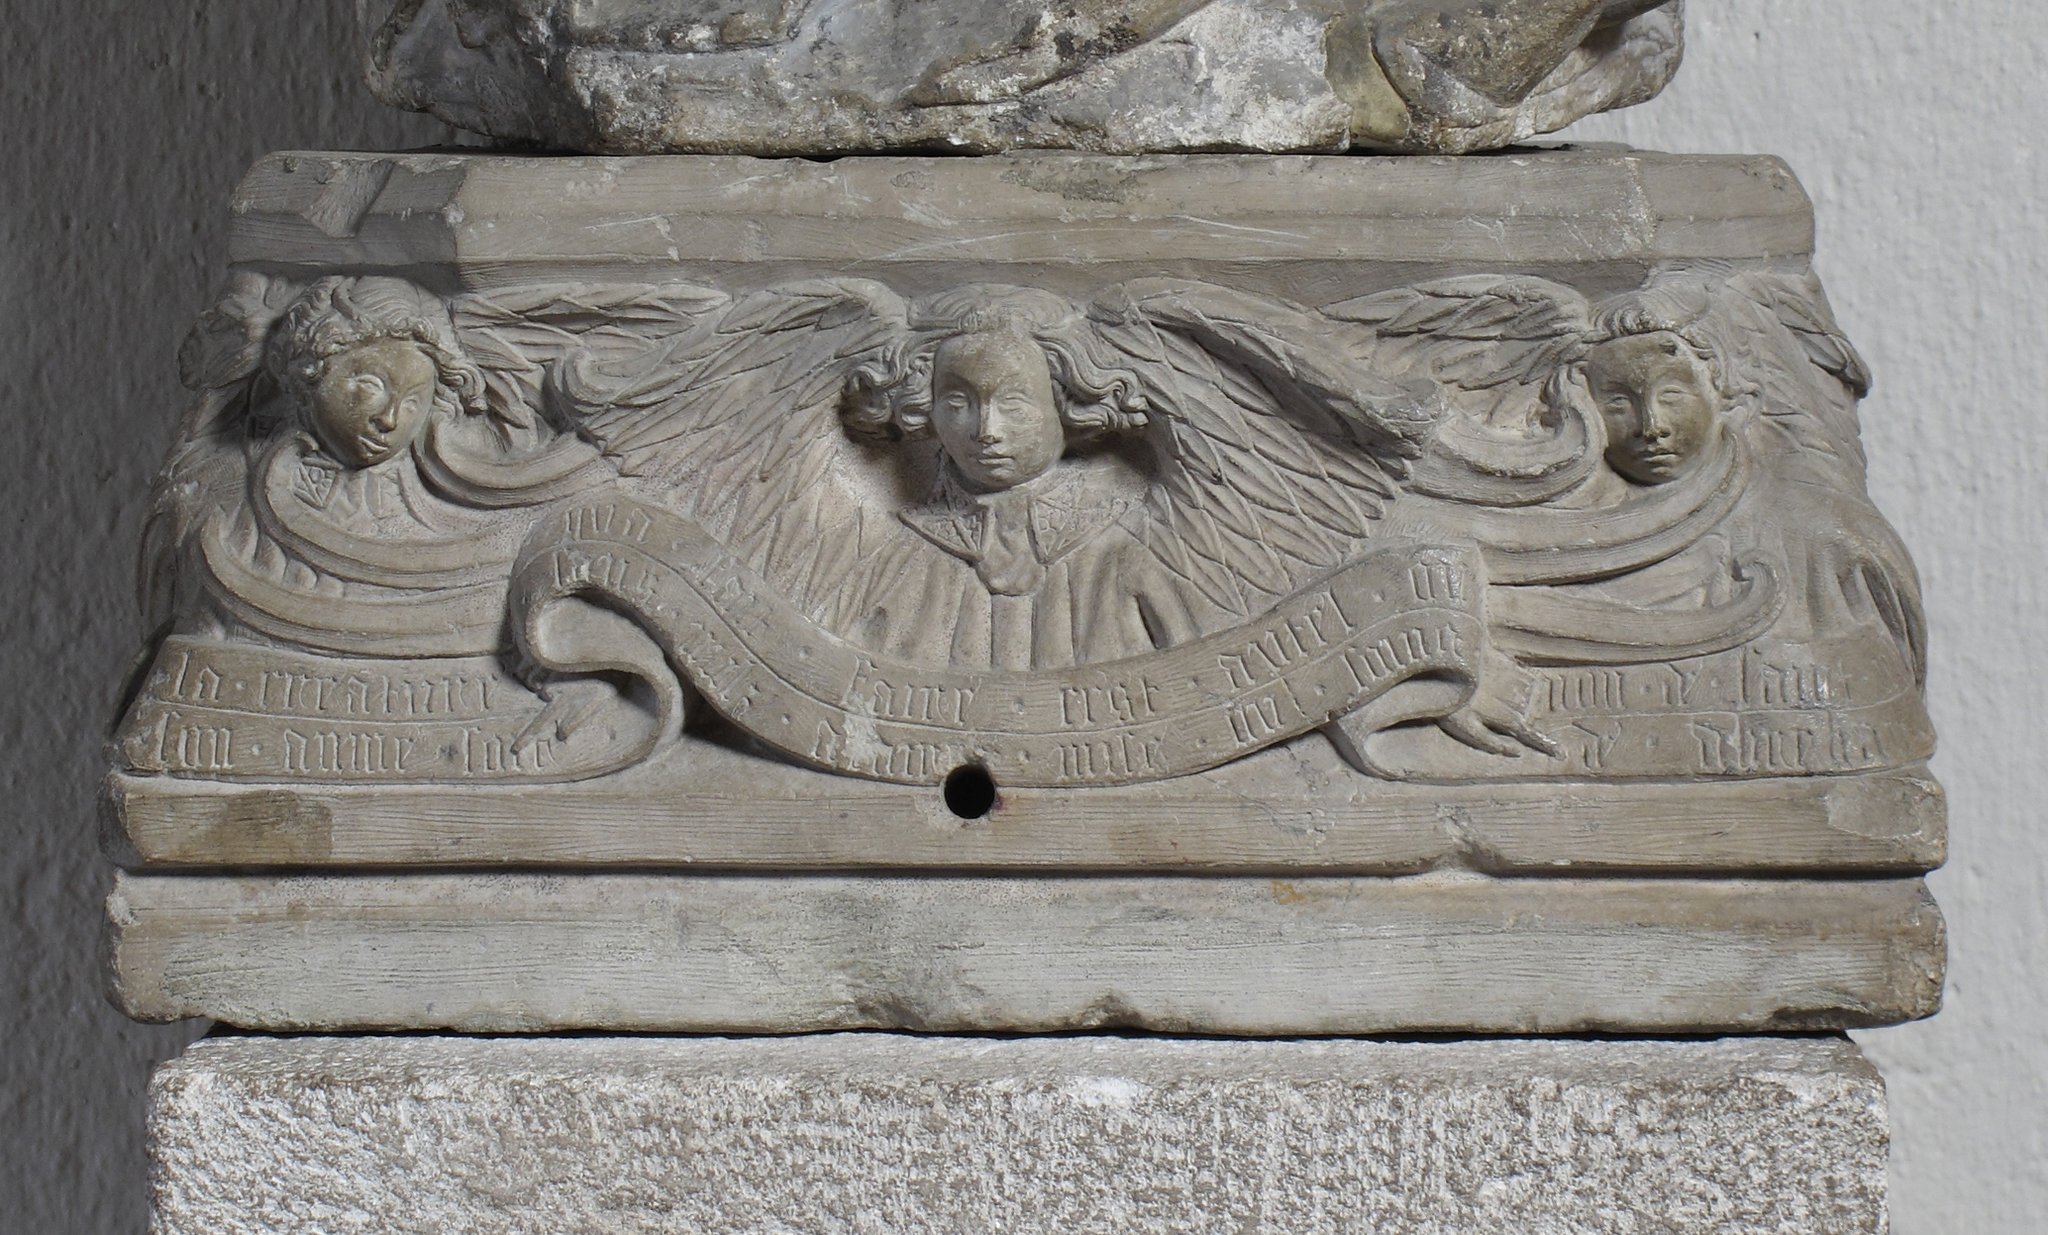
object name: altar pedestal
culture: french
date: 1400-1425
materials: limestone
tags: angels